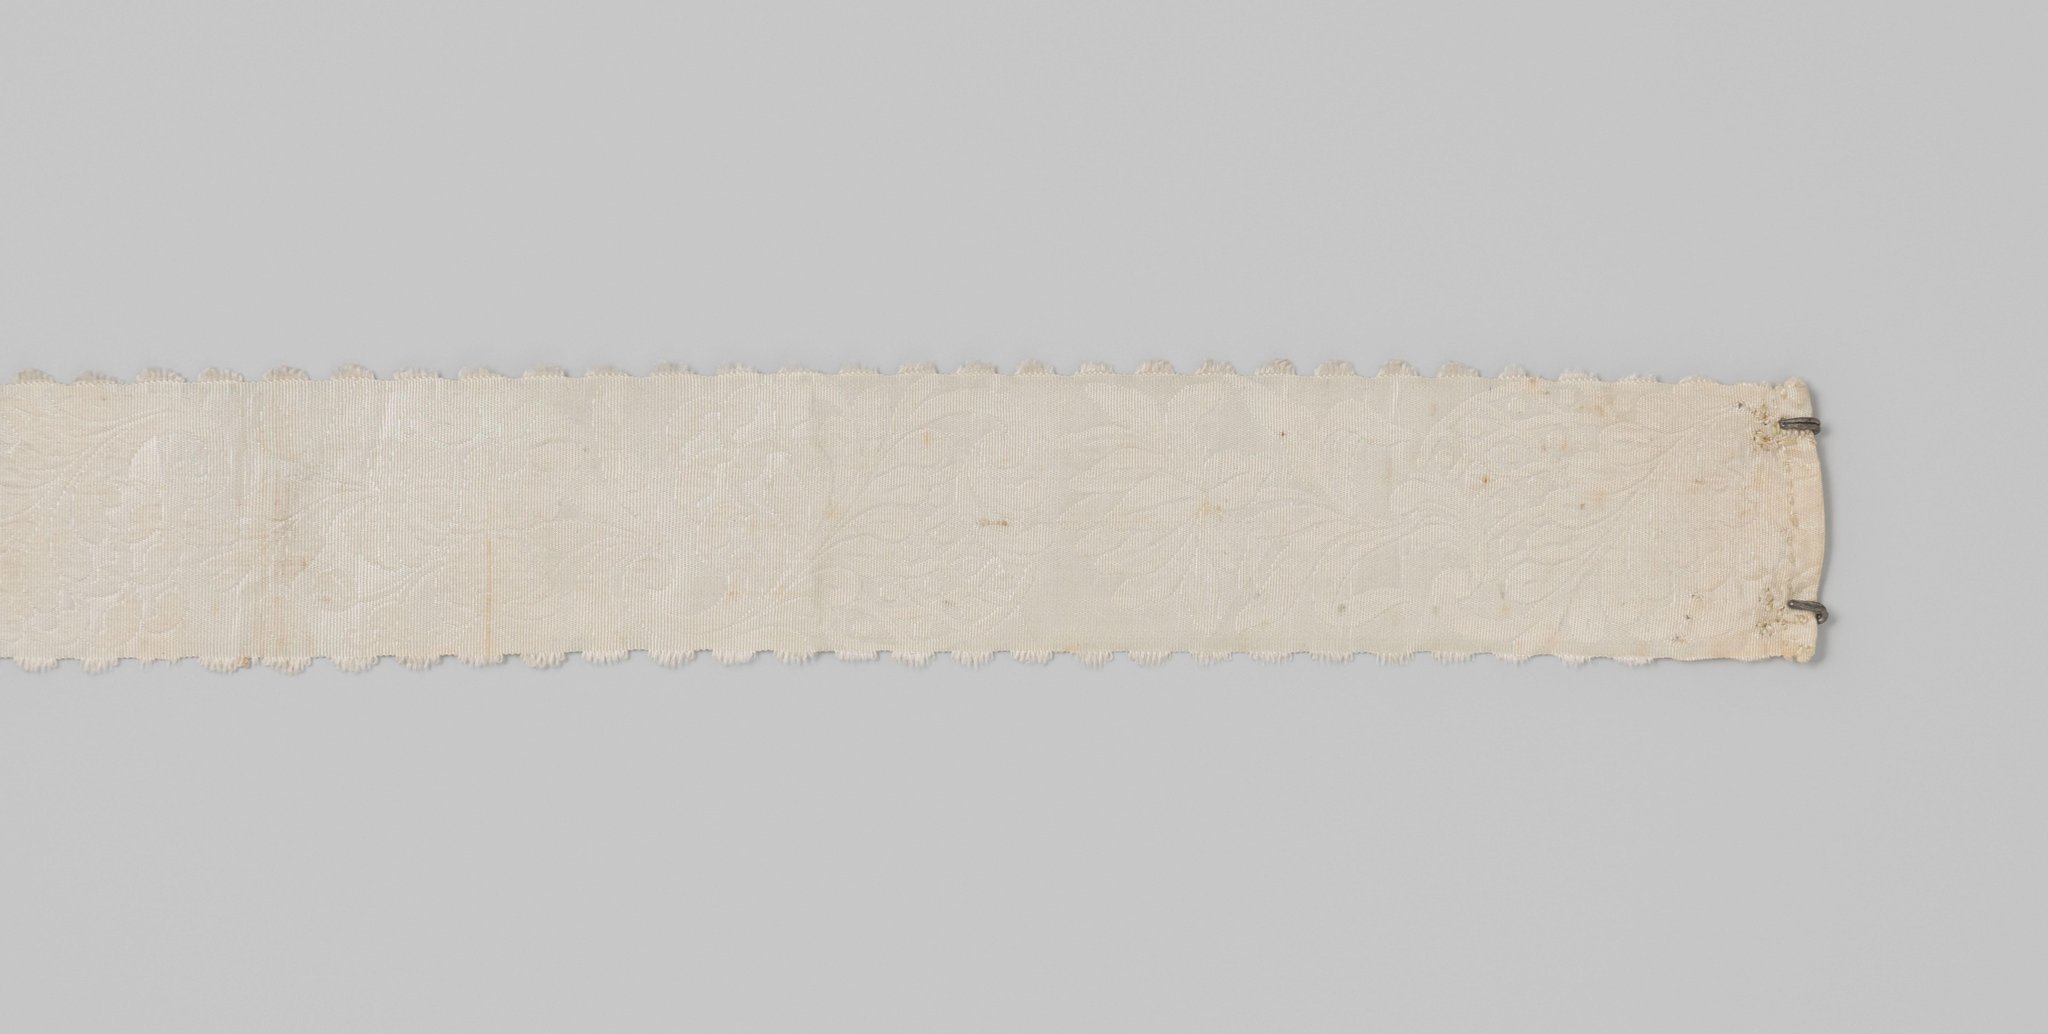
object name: ribbon material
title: Gordellint van witte ripszijde met ingeweven bloempatroon; aan beide korte uiteinden van het lint zijn haakjes en oogjes bevestigd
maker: Anonymous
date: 1800-1820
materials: silk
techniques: rib binding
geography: netherlands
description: Gordellint van witte ripszijde met ingeweven bloempatroon. Aan beide korte uiteinden van het lint zijn haakjes en oogjes bevestigd.